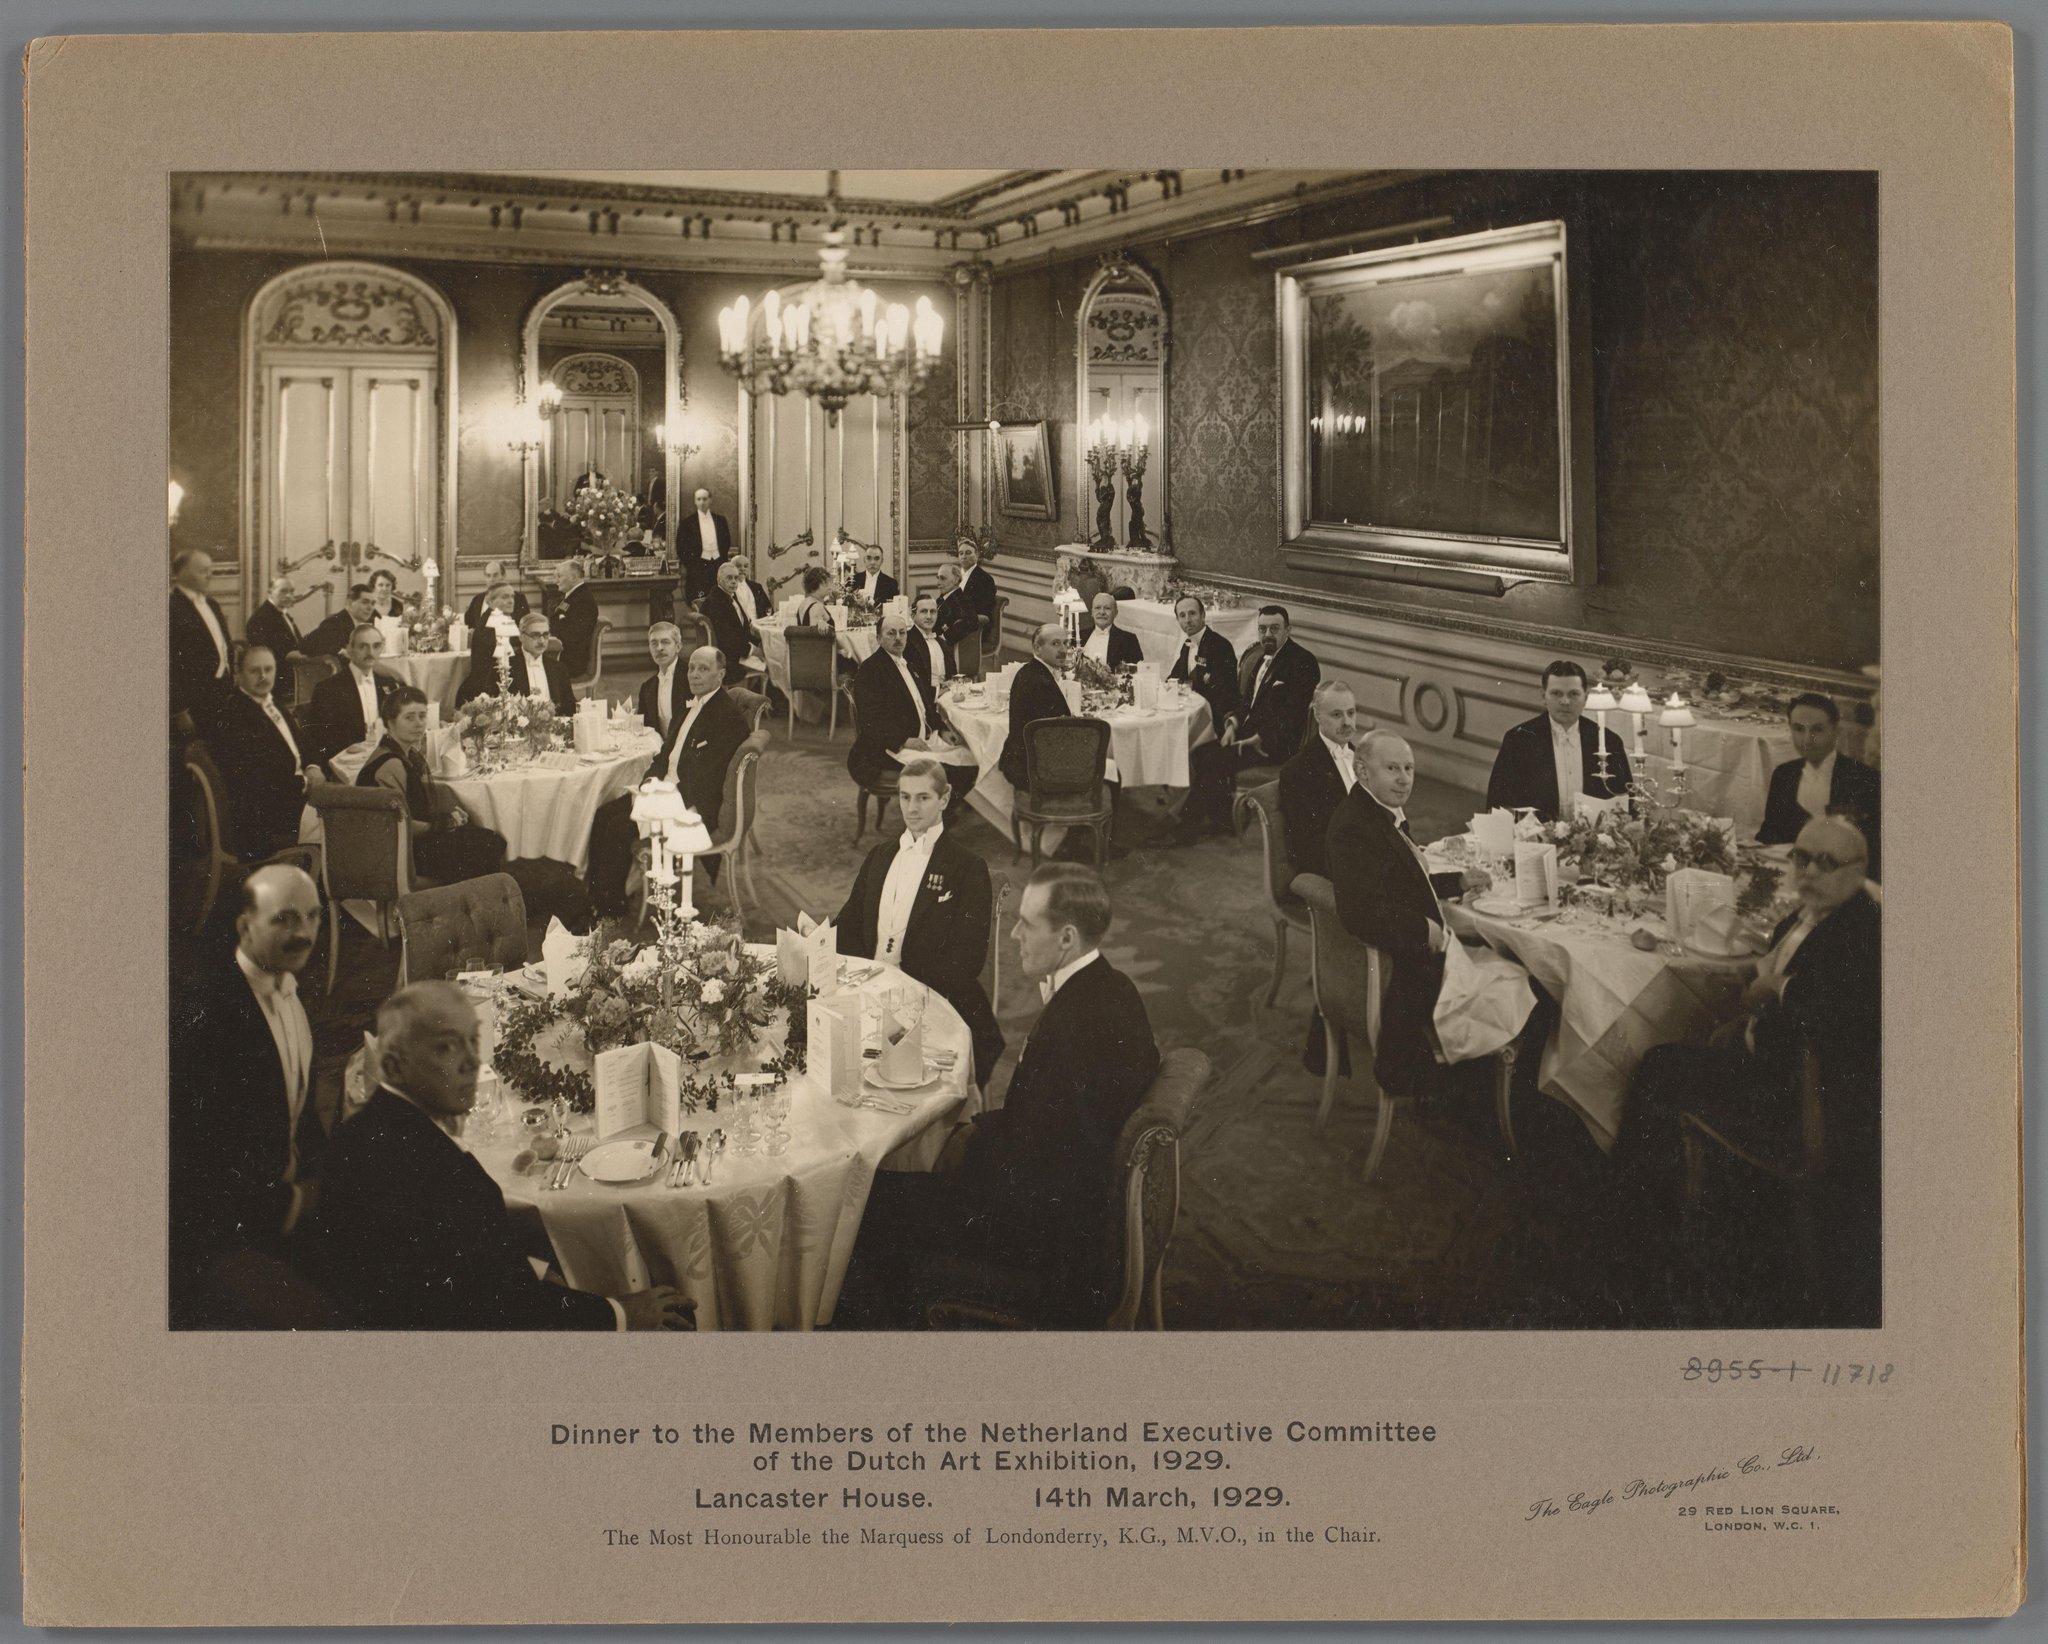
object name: photograph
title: Diner voor de opening van de Dutch Art Exhibition in Londen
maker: Anonymous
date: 1929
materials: paper, cardboard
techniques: gelatin silver print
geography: london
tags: dress, gown: dinner dress, evening meal, dinner, supper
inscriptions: inscription: ‘Lancaster House. 14th March 1929./ The Most Honourable the Marquess of Londonderry, K.G., M.V.O., in the Chair.’, stamp: ‘Archief/ Rijksmuseum’, inscription: ‘[...] 16/ fotonegatief/ 26159 18/24 cz’, address: ‘29 Red Lion Square,/ London, W.C. 1.’